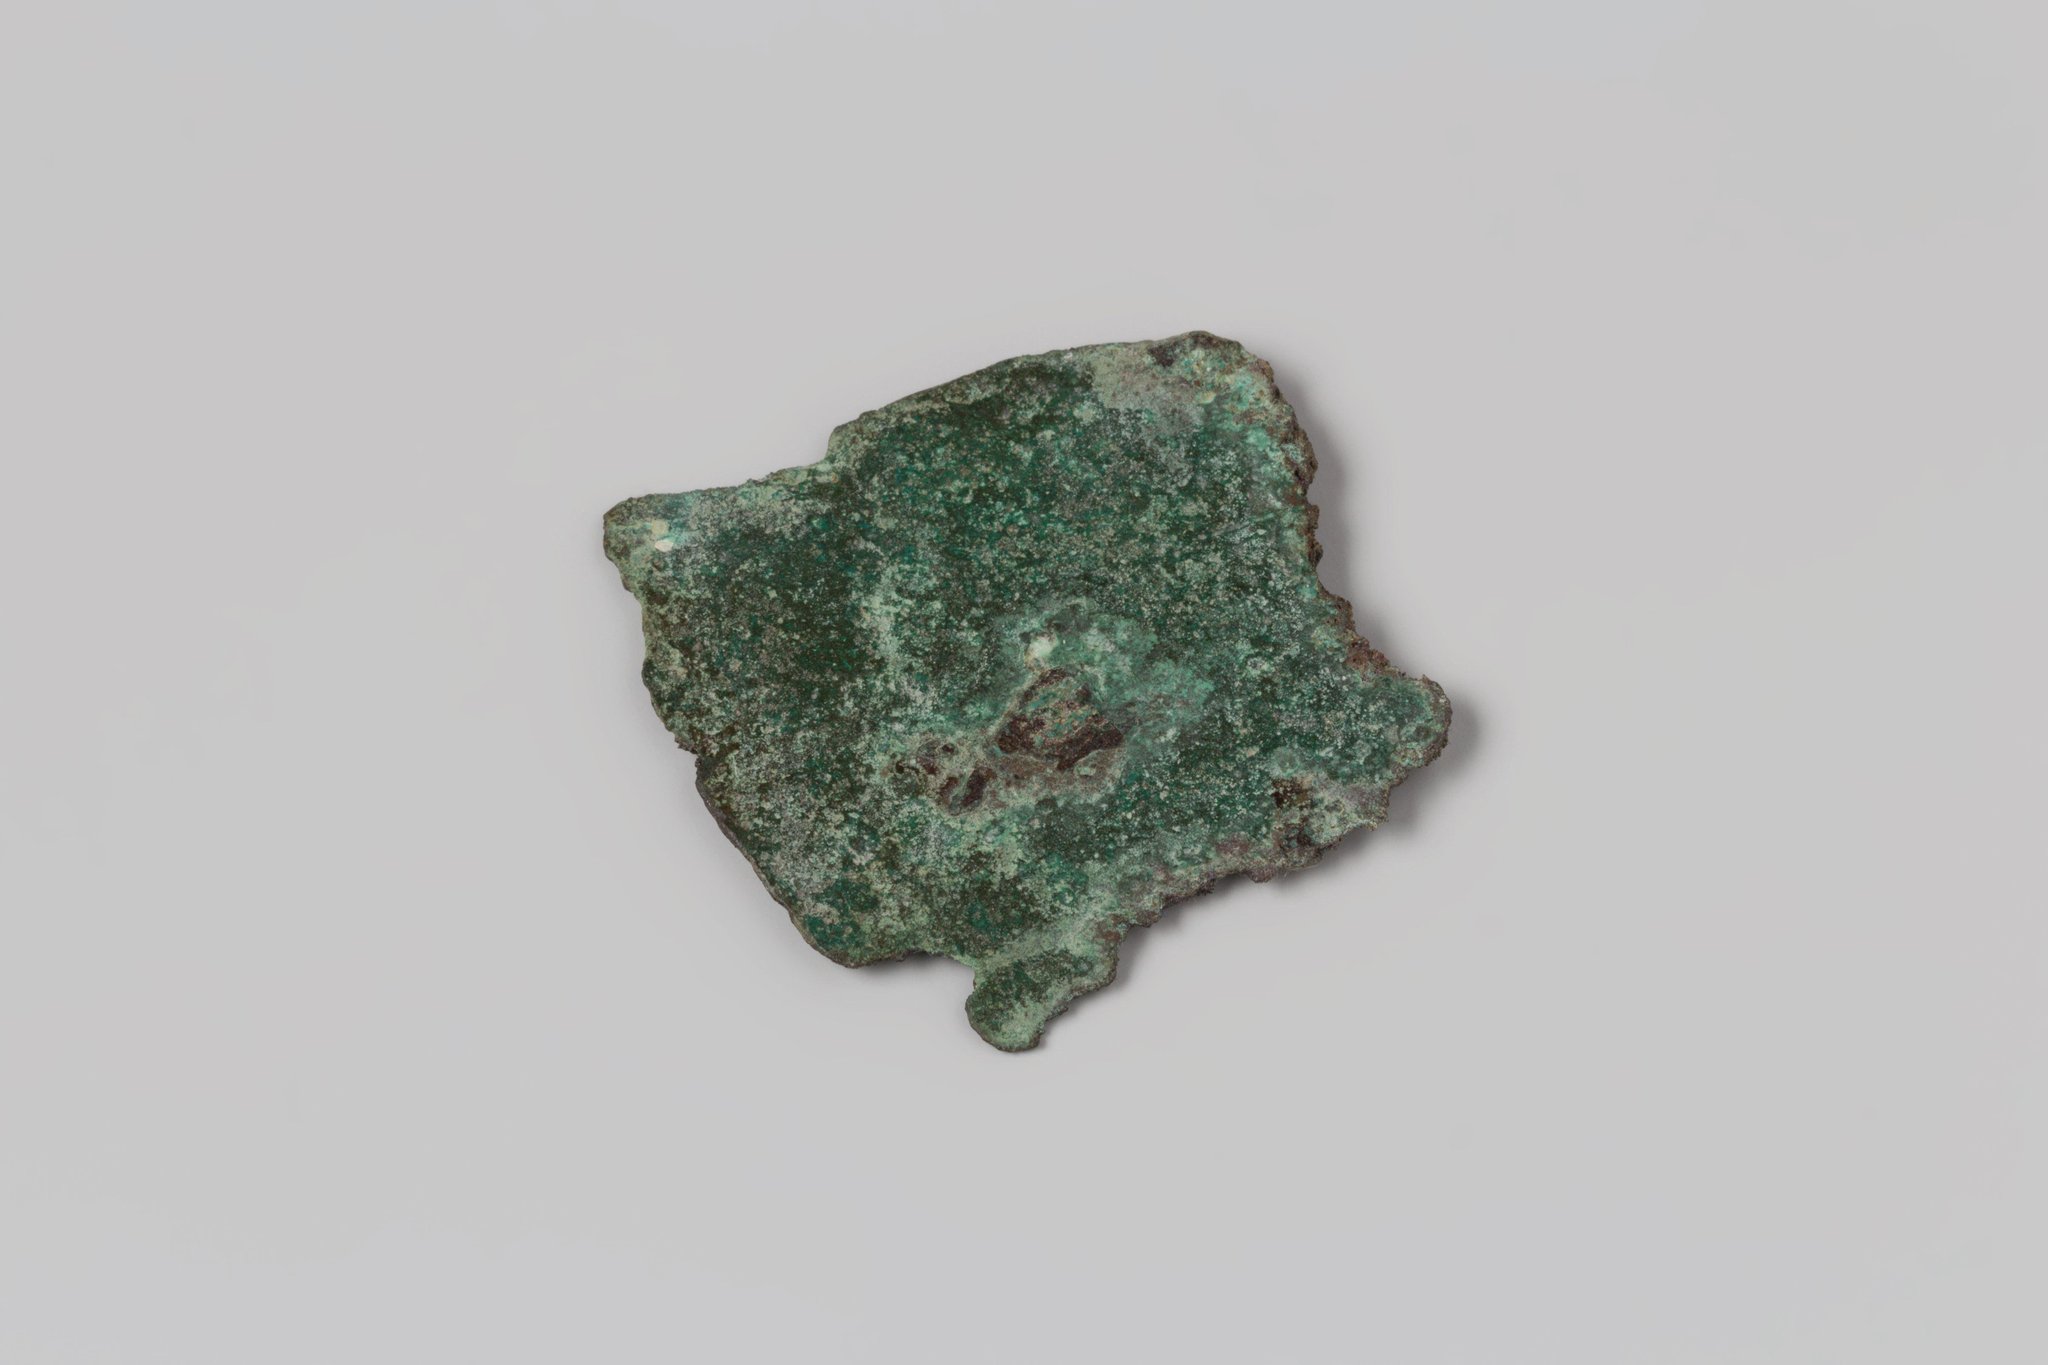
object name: scheepswrakvondst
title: Fragment van koper uit het wrak van de Oost-Indiëvaarder Hollandia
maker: Anonymous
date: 1700-1743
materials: copper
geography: netherlands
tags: verenigde oostindische compagnie, hollandia (schip), annet